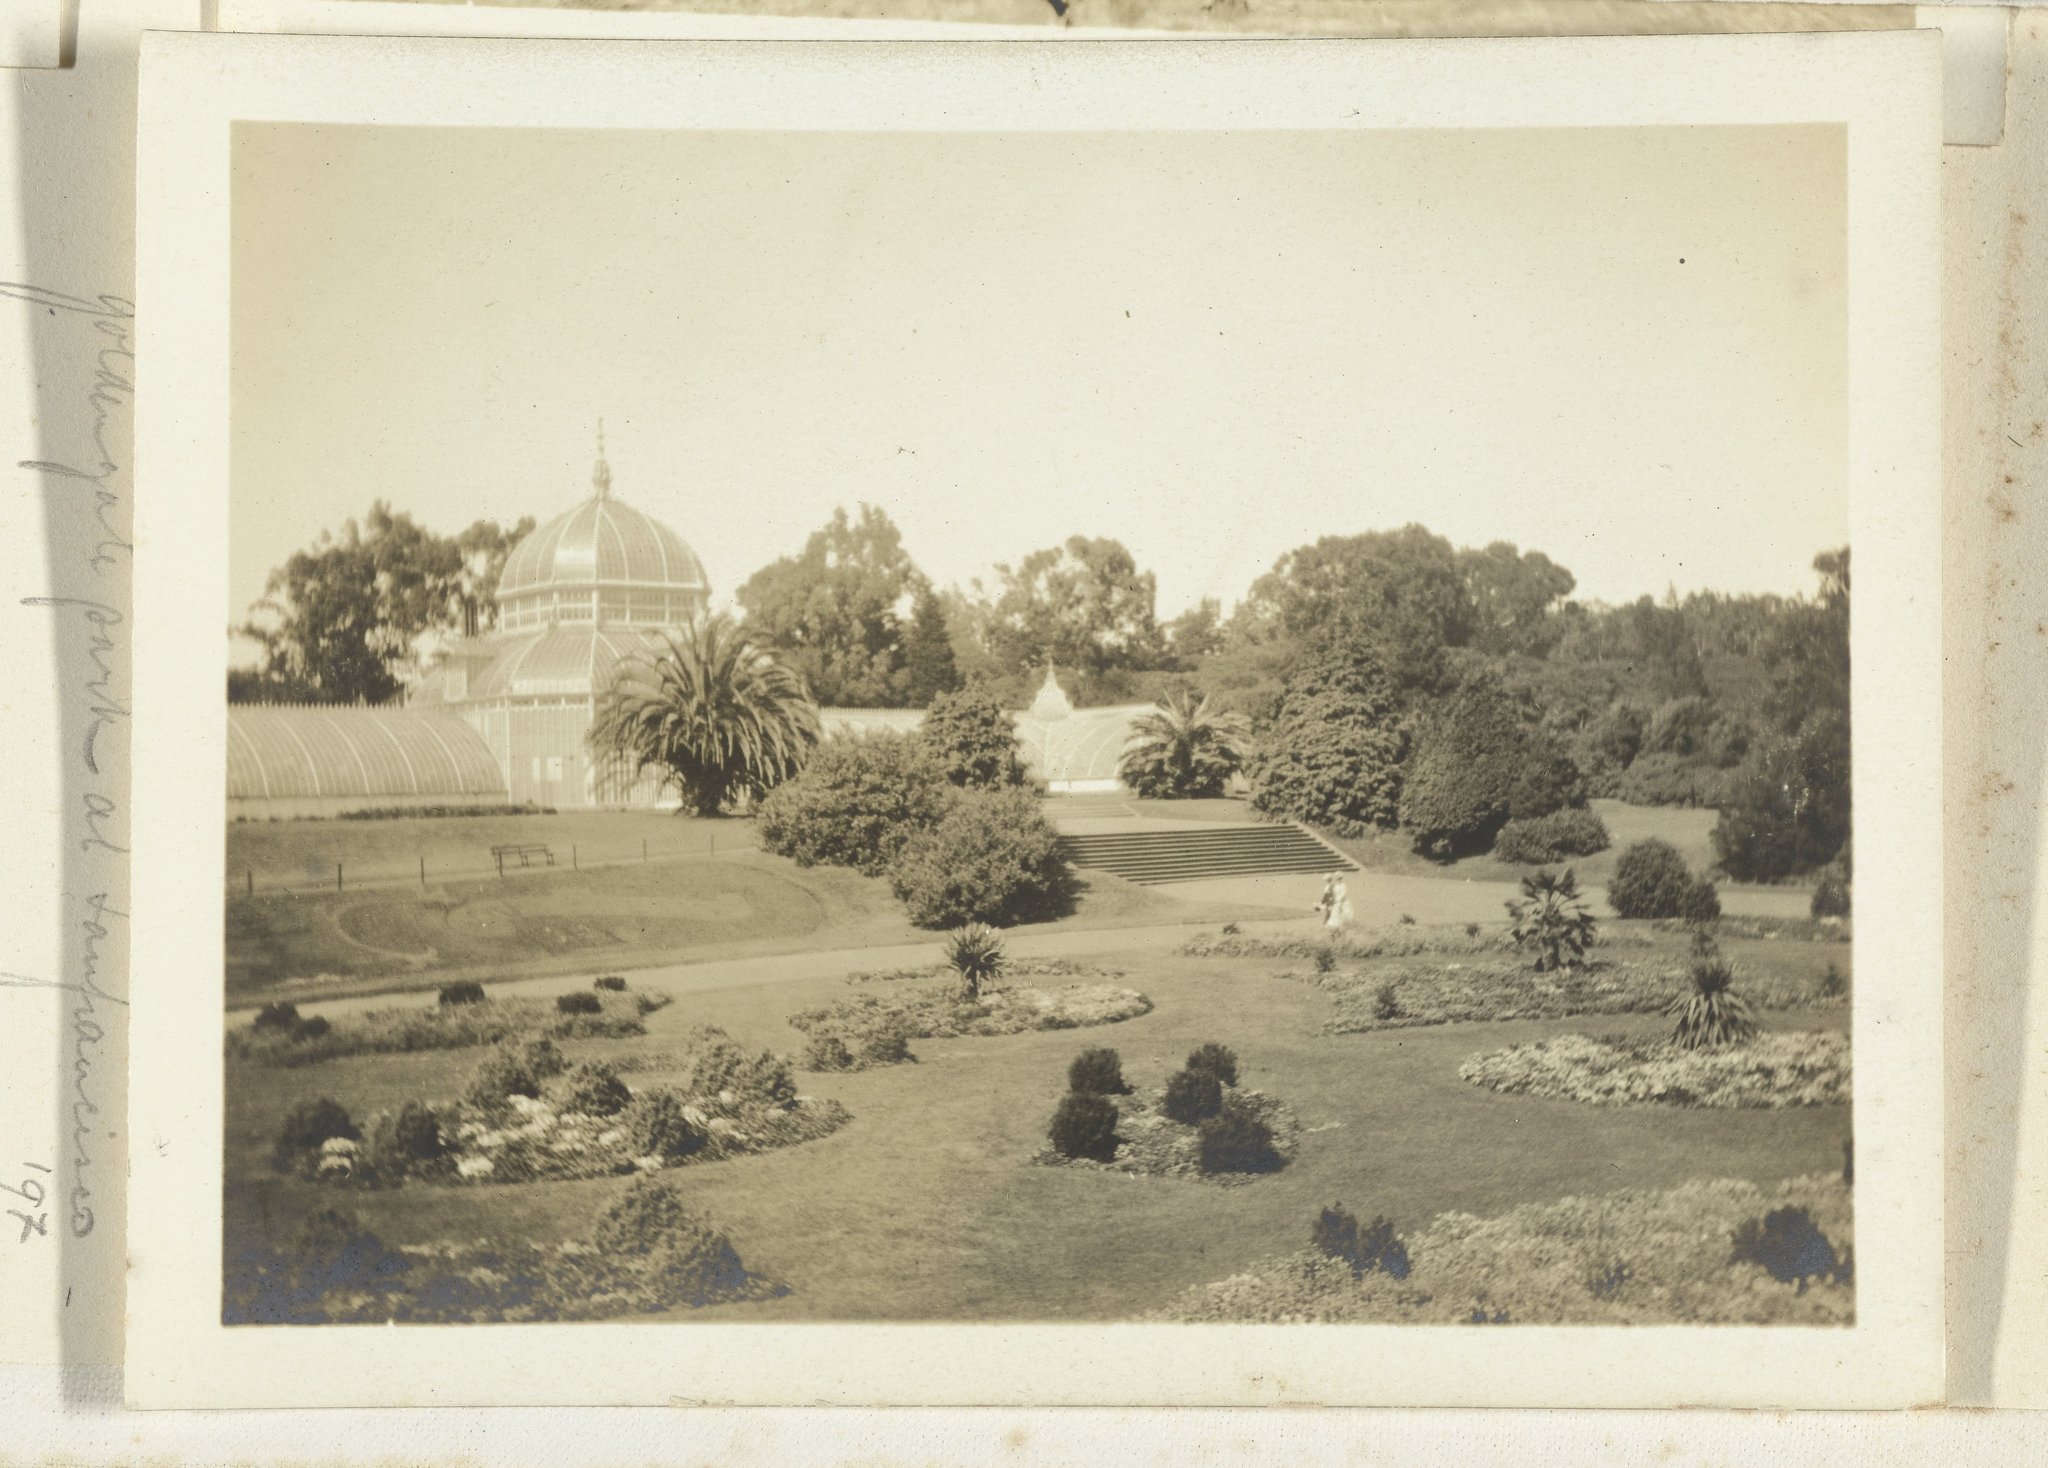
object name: photograph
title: Golden gate park at San Francisco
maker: geldolph adriaan kessler (dolph)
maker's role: fotograaf, industrieel, voetballer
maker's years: 1884-1945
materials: cardboard, photographic support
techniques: gelatin silver print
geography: san francisco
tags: san francisco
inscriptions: title: ‘Golden gate park at San Francisco’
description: Het Golden Gate park in San Francisco met uitzicht op de koepel. Onderdeel van het fotoalbum van Dolph Kessler met opnamen die hij maakte tijdens zijn verblijf in Engeland en op een wereldreis die hij als secretaris van Henri Deterding (directeur Koninklijke Olie) ondernam naar Nederlands-Indië, Japan, China en de Verenigde Staten, tussen 1906 en 1908.